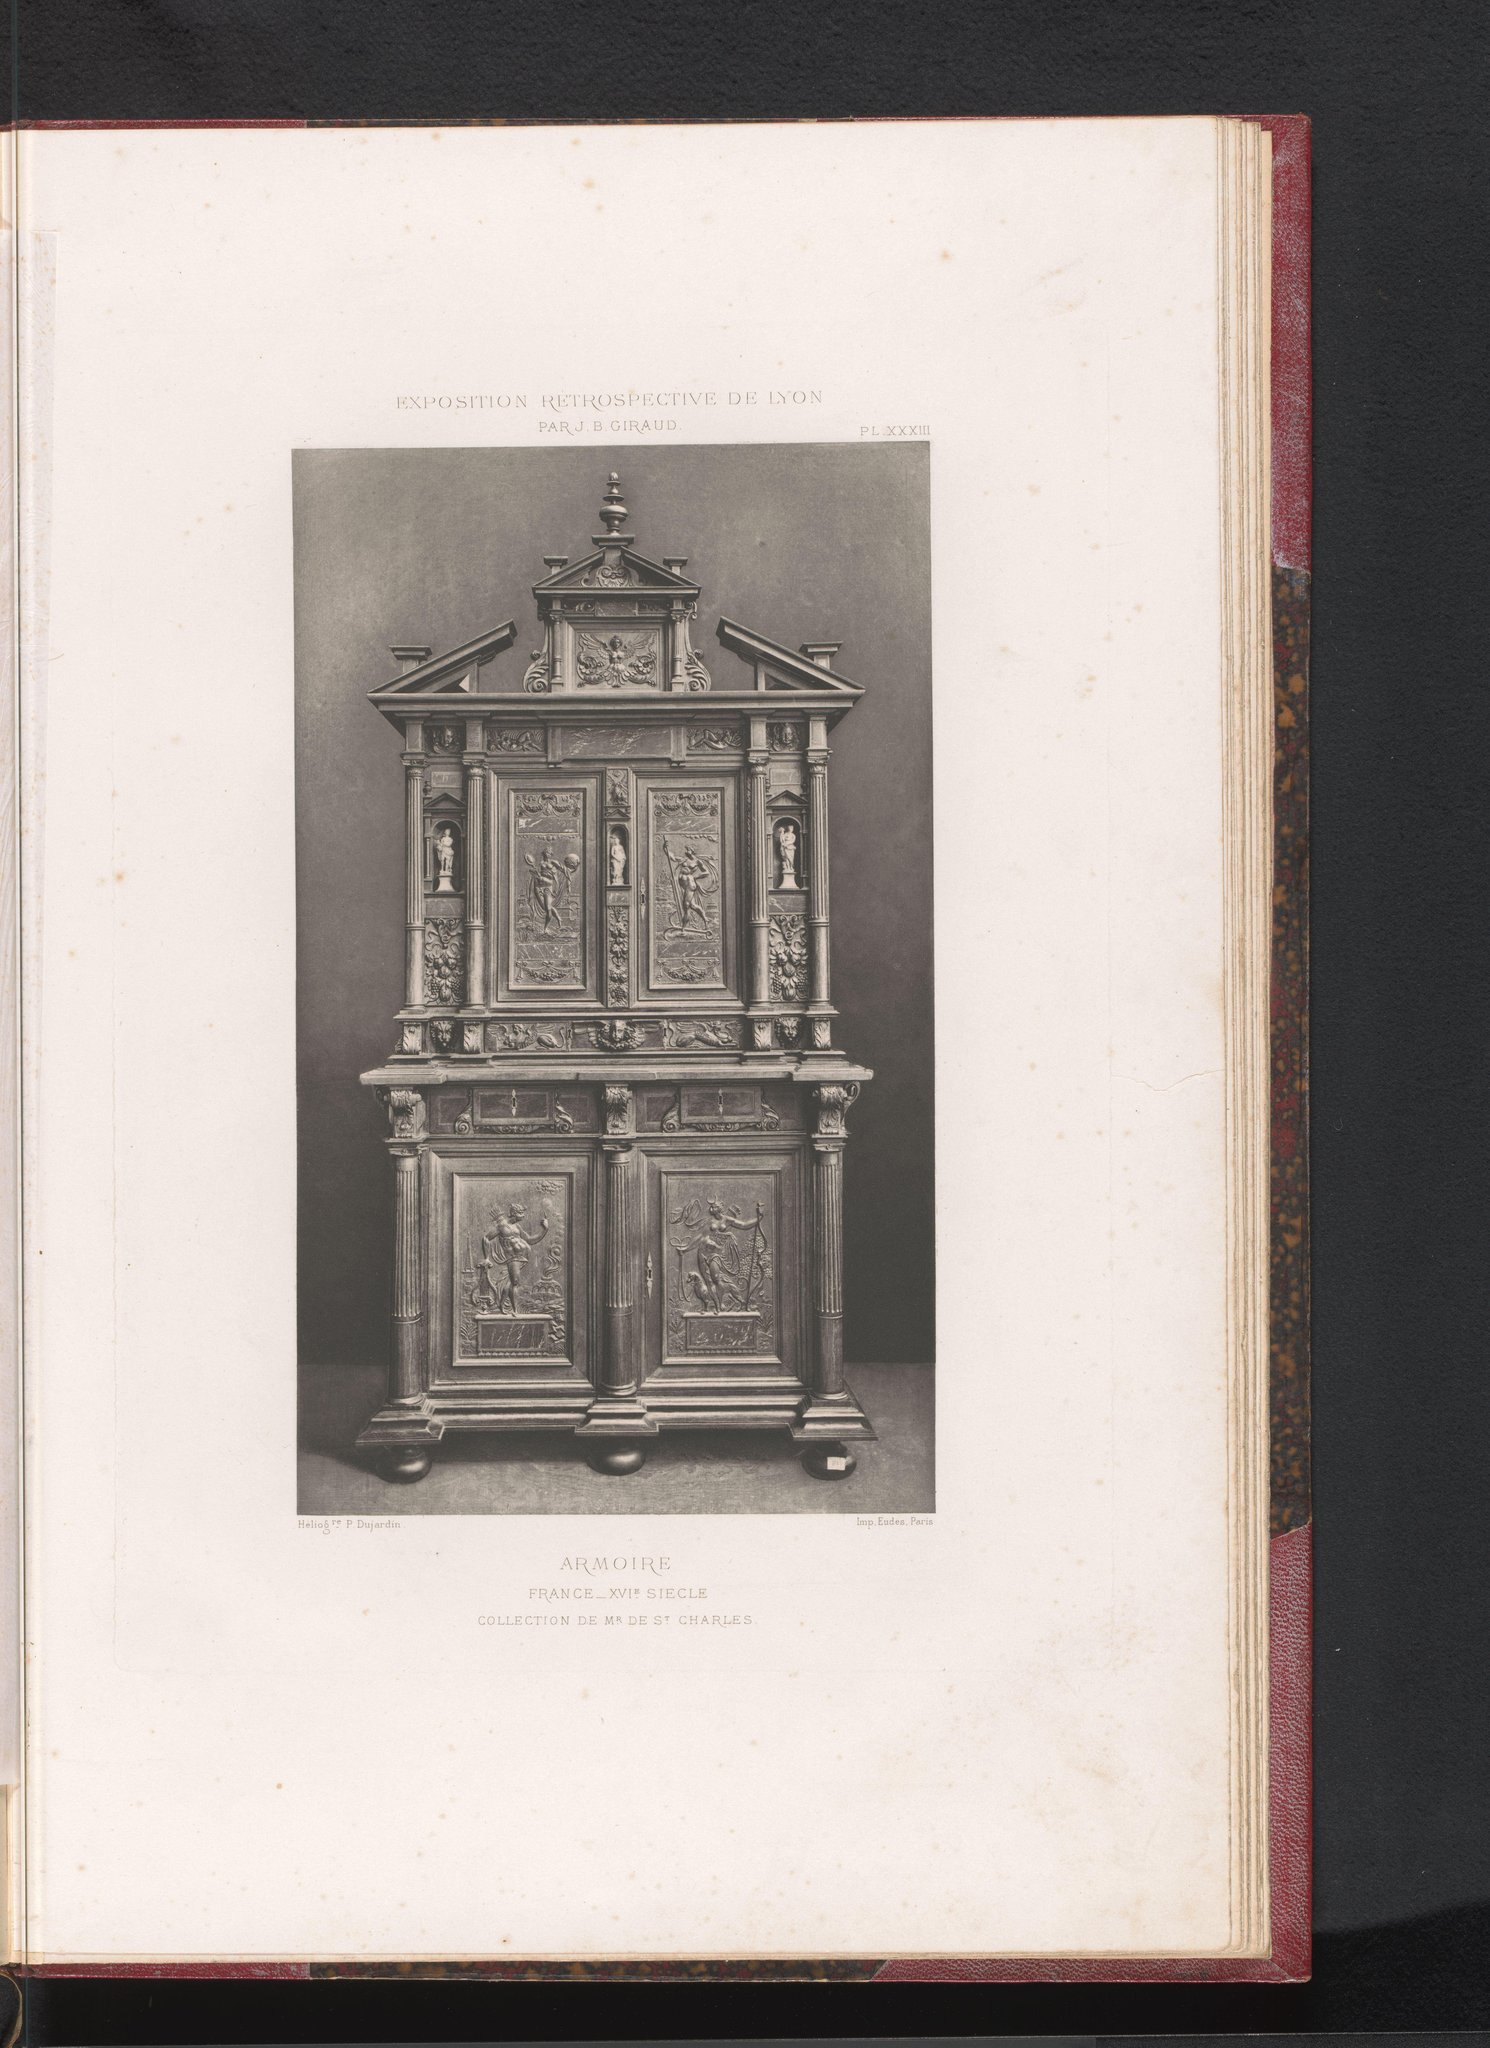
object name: photomechanical print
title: 16de-eeuwse Franse kast van hout, op de Exposition Rétrospective van 1877 in Lyon, Frankrijk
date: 1877-1880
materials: paper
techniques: photoaquatint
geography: lyon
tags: ornamental cupboard (+ wood and other phytogenic material), lyon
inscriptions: inscription: ‘ARMOIRE/ FRANCE_XVIe SIÈCLE/ COLLECTION DE Mr DE St CHARLES.’, inscription: ‘EXPOSITION RÉTROSPECTIVE DE LYON/ PAR J. B. GIRAUD.’, number: ‘PL. XXXIII.’